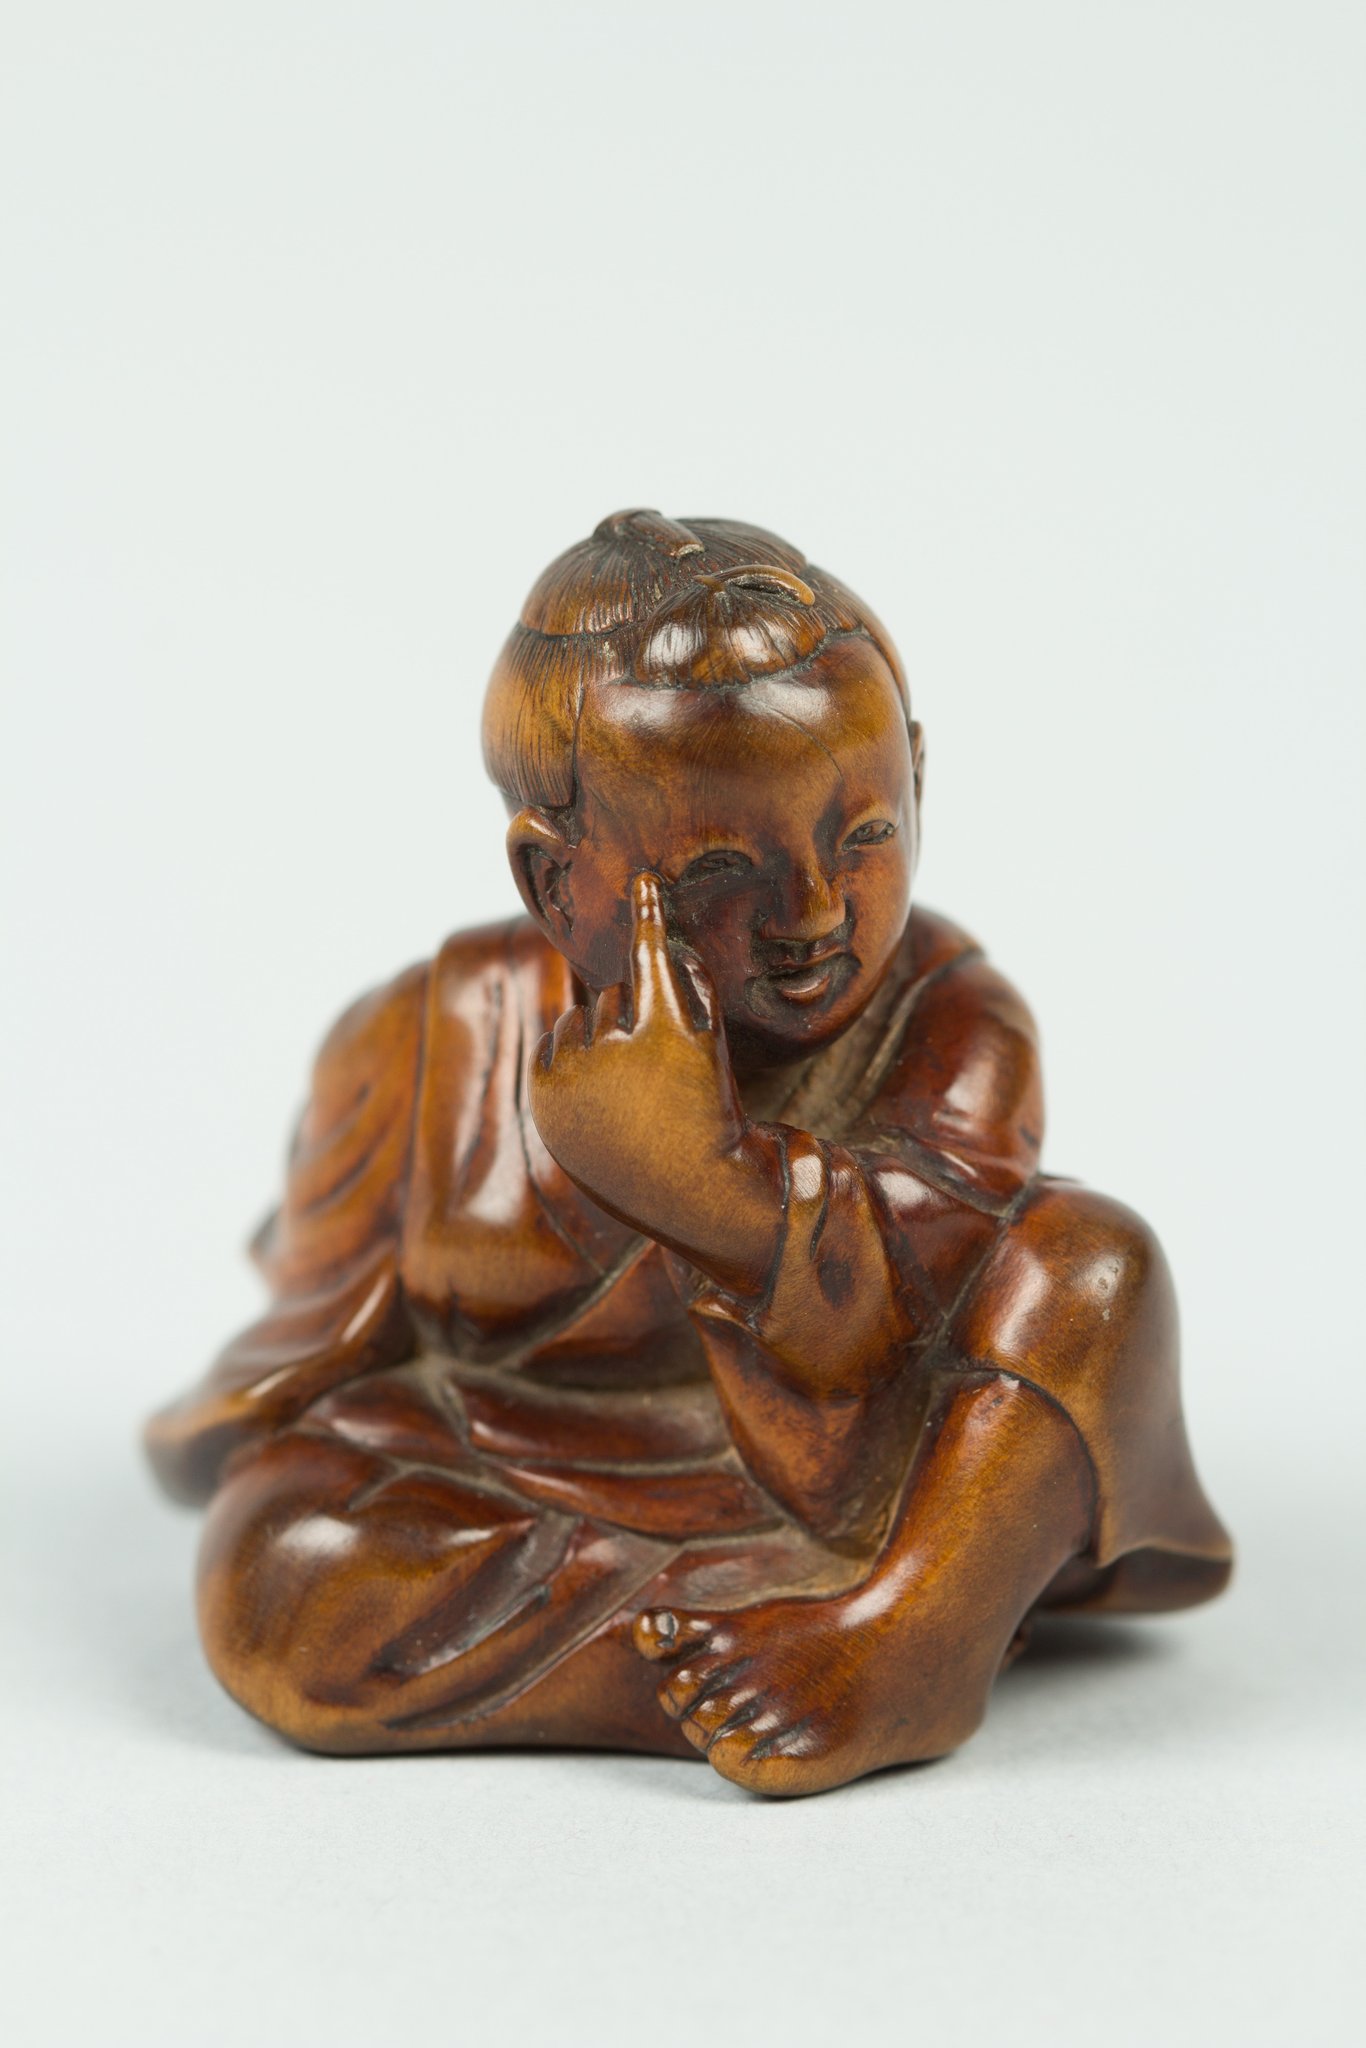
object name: netsuke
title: Netsuke of Boy with a Mask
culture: japanese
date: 1801-1900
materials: wood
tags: masks,boys